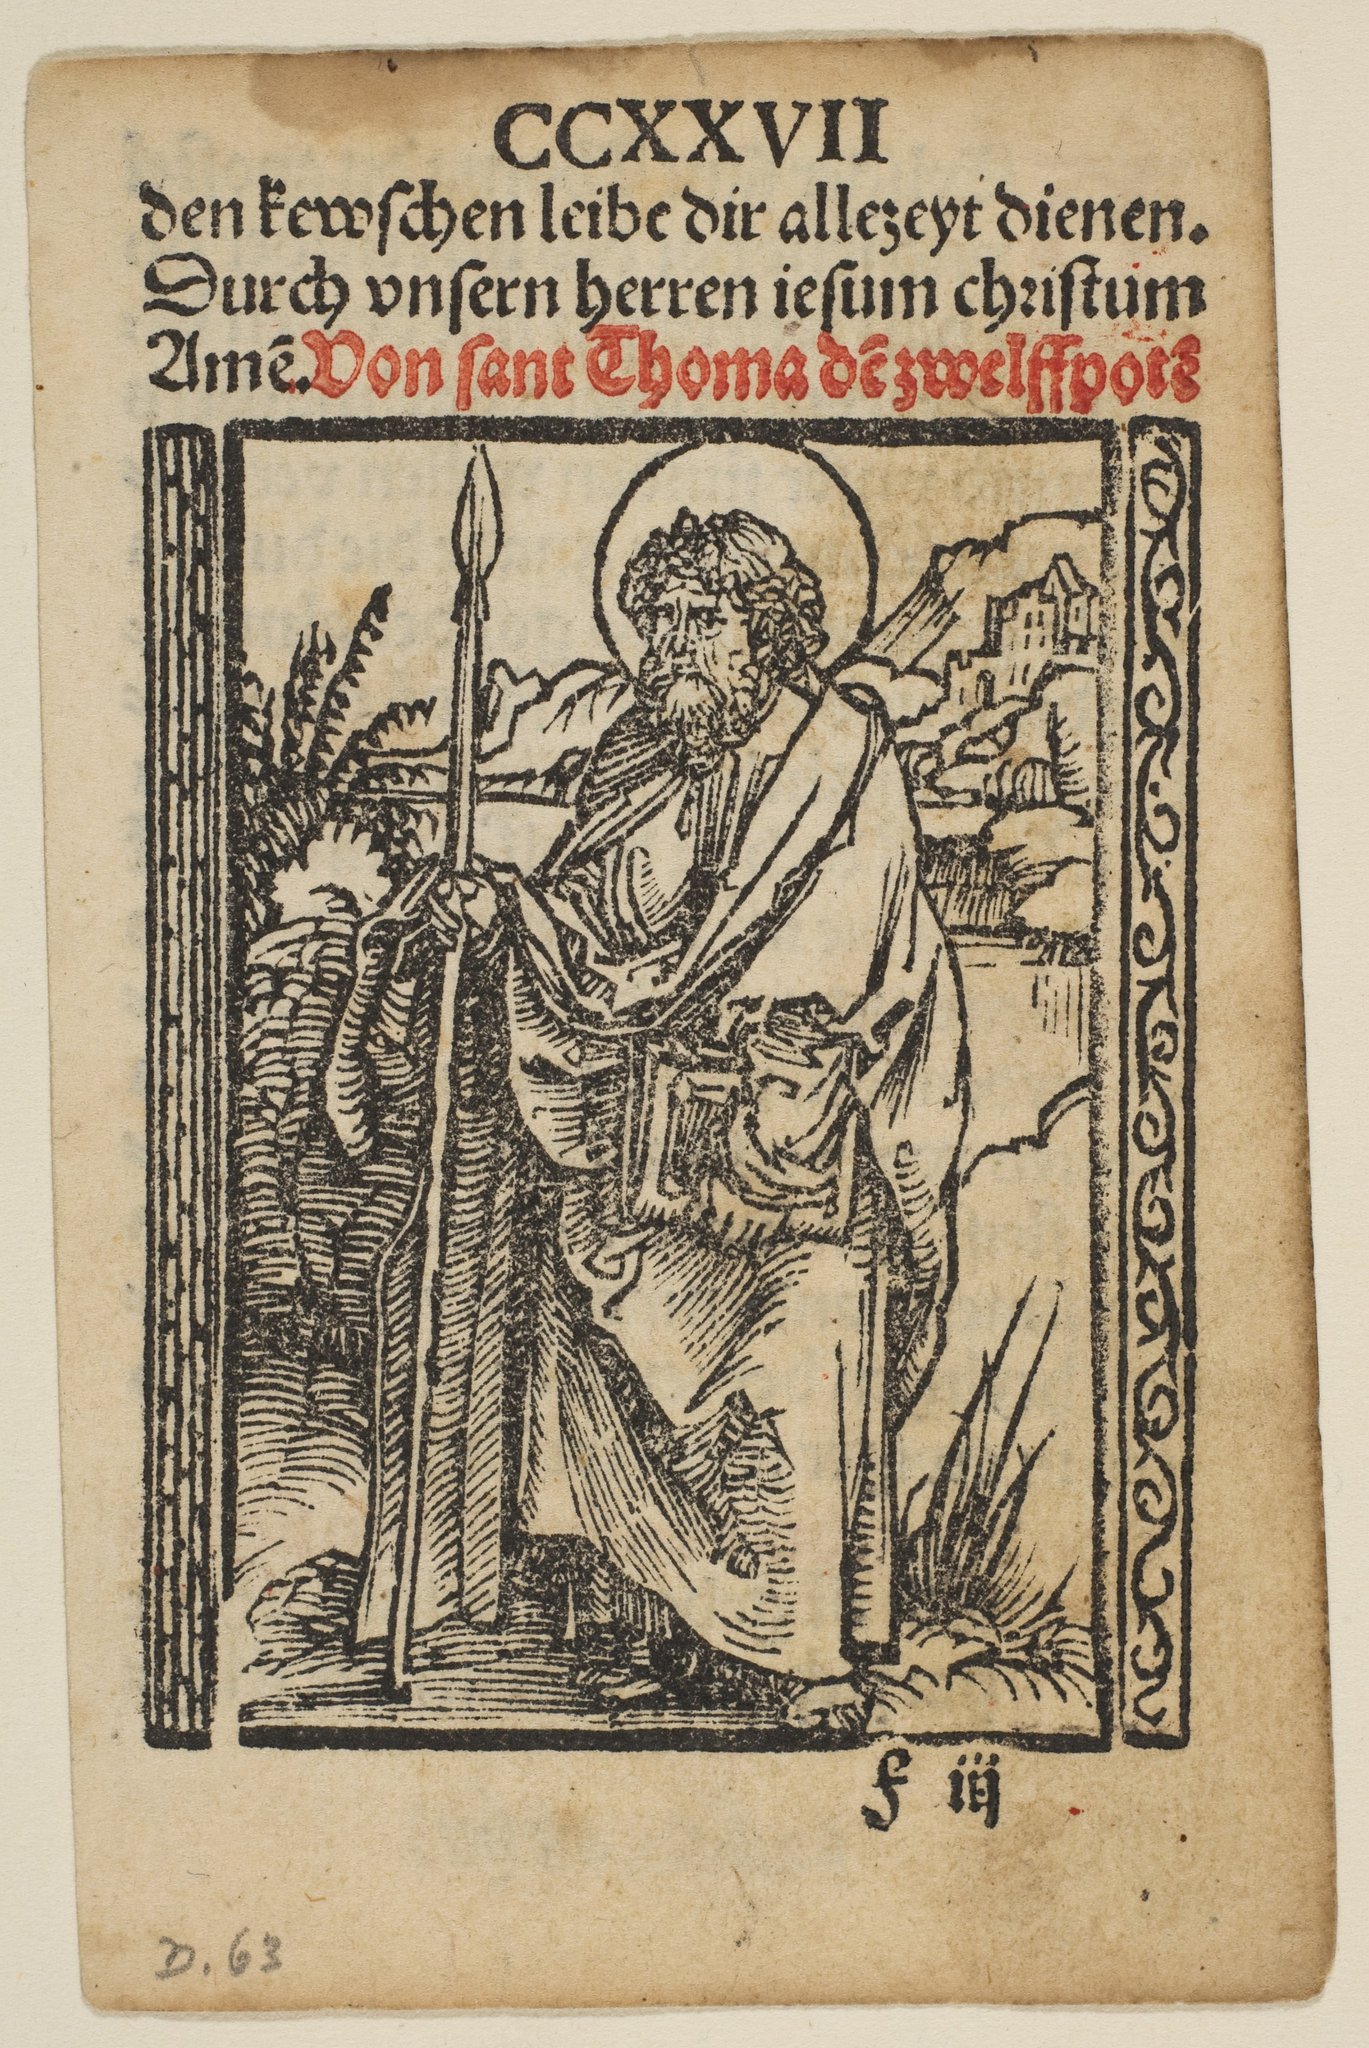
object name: print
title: Religious scenes used in Salus Anime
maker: albrecht dürer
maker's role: artist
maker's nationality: german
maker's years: 1471-1528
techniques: woodcut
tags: spears,men